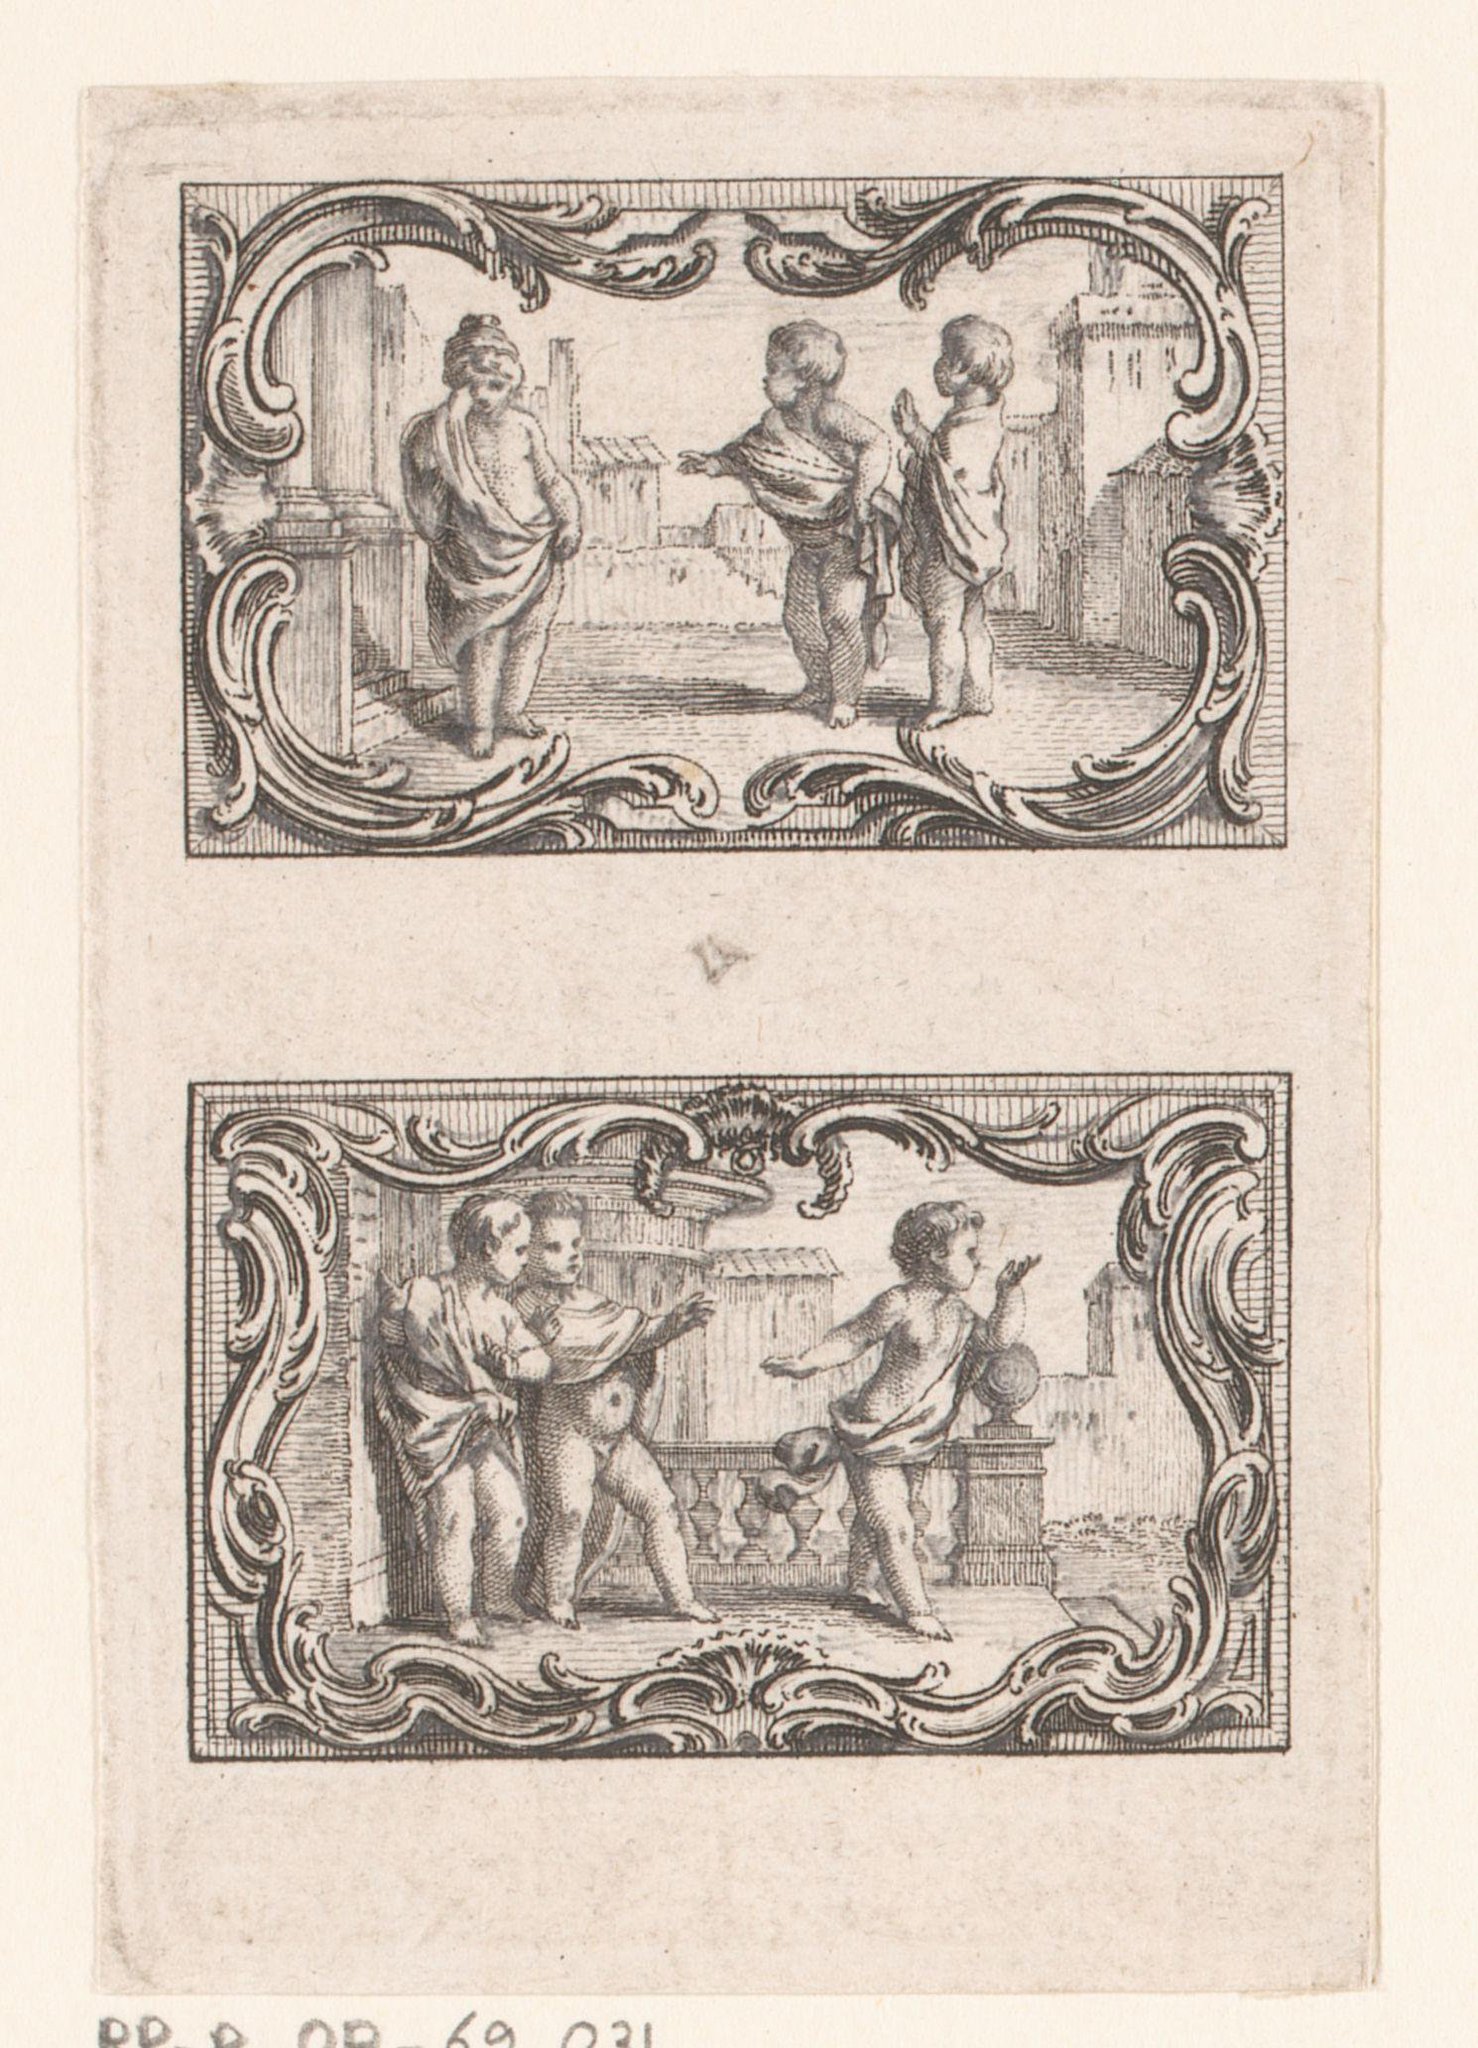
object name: print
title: Twee vignetten met drie putti temidden van gebouwen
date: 1717-1783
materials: paper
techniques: etching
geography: paris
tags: vignette, cupids: 'amores', 'amoretti', 'putti'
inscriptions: collector's mark: Lugt 2228